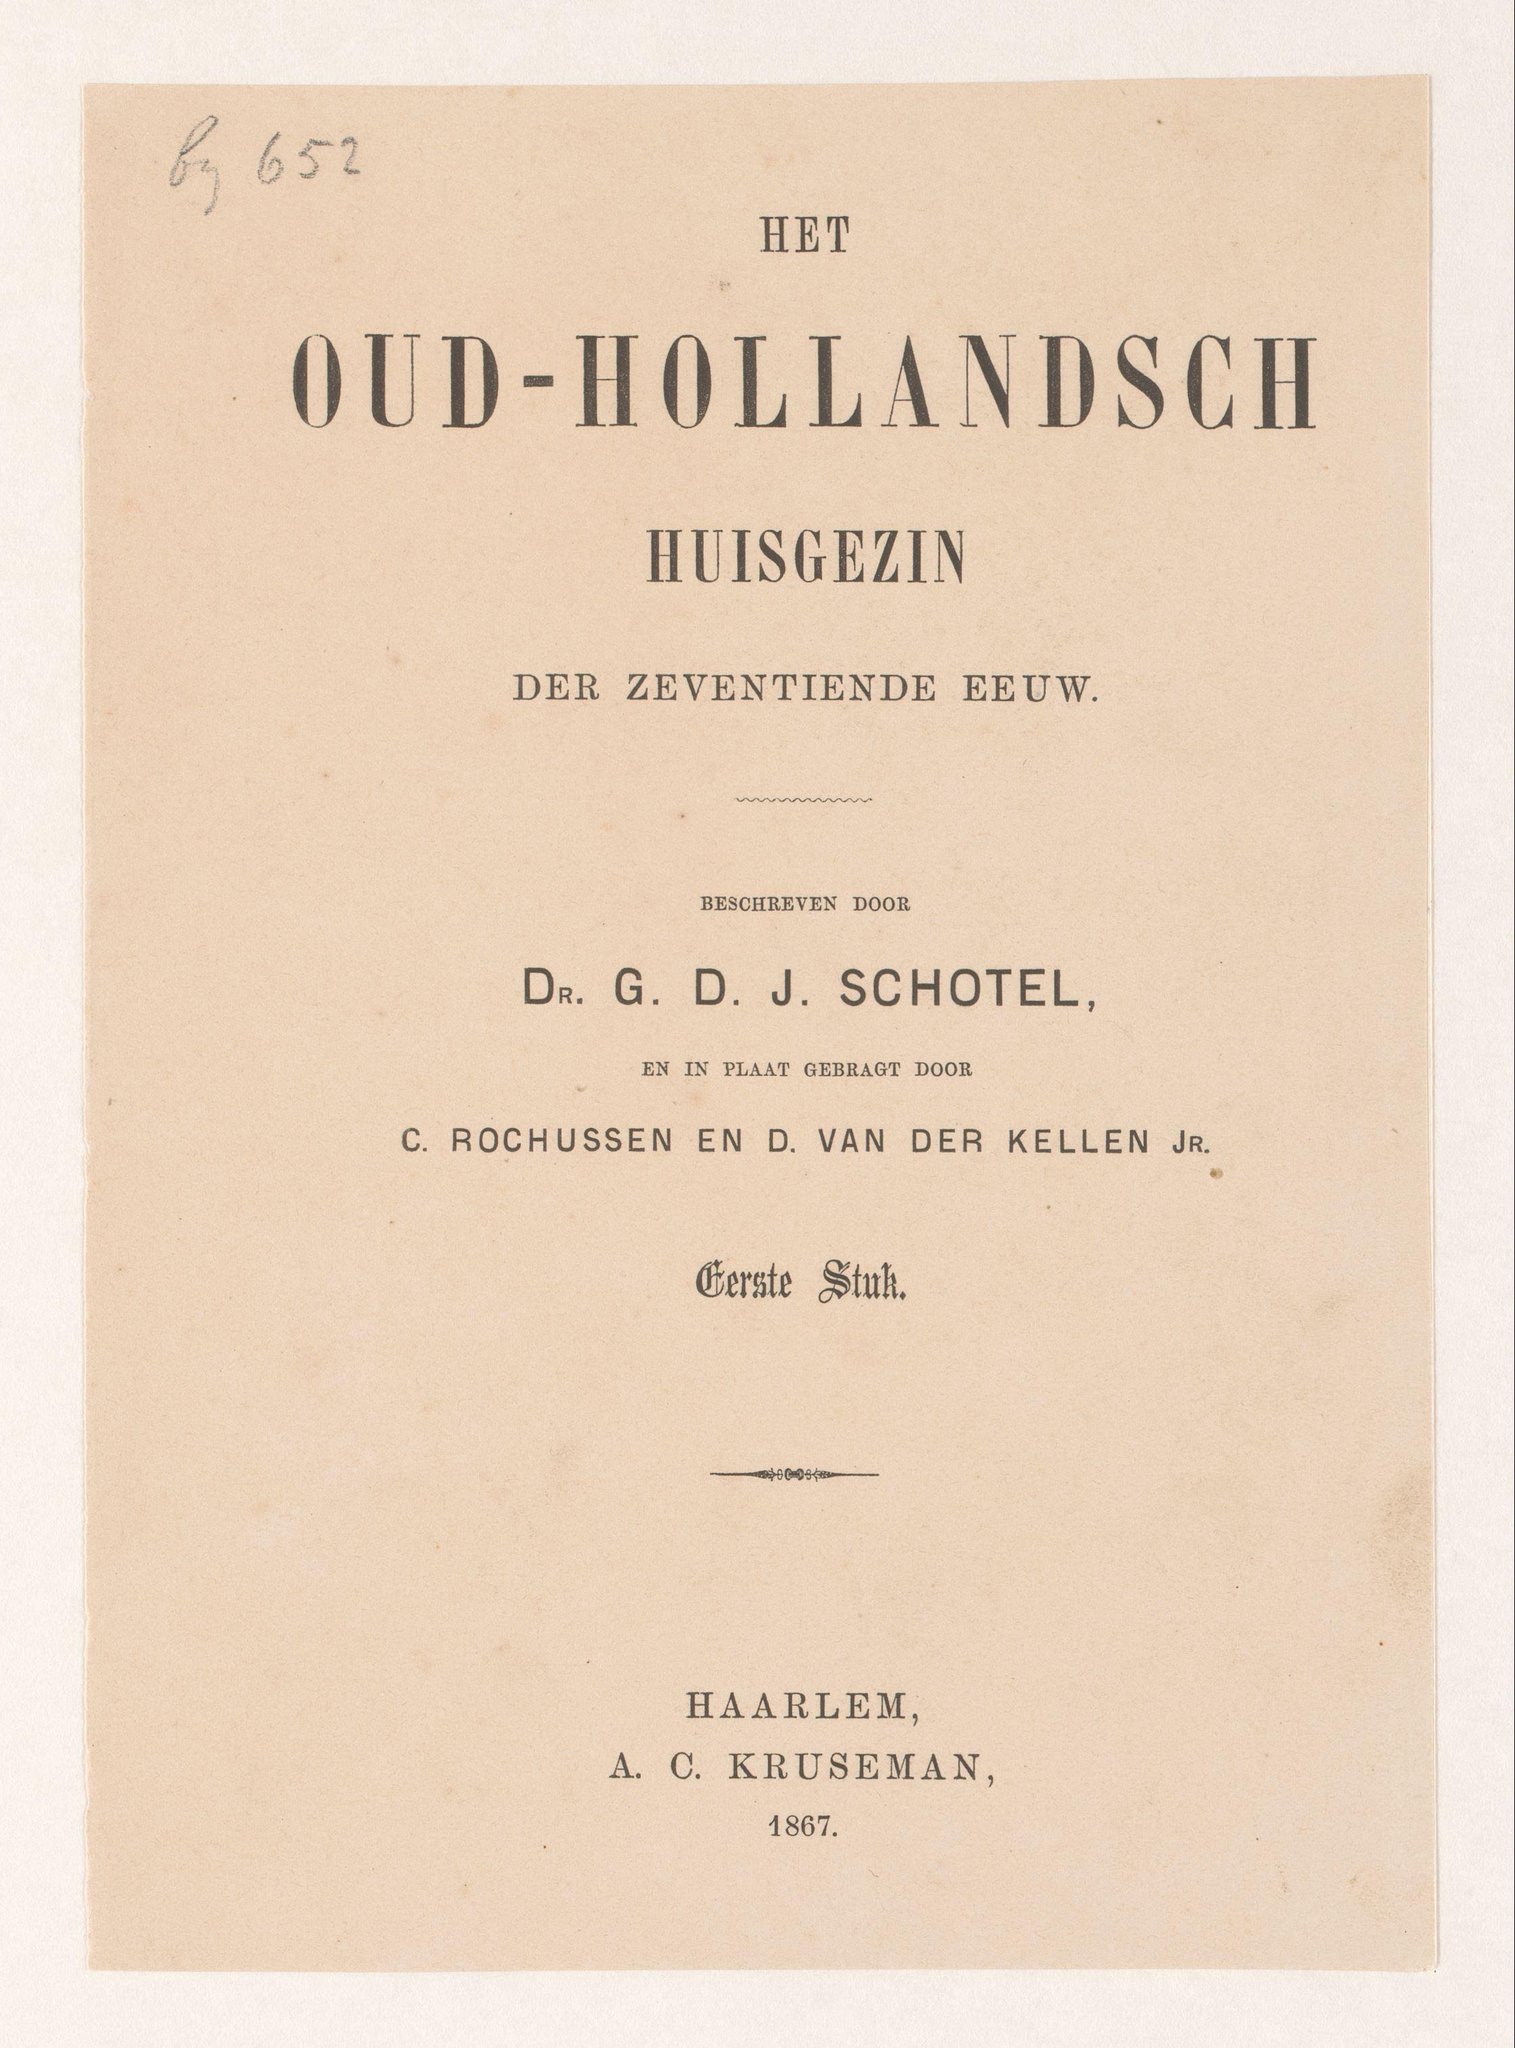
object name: print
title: Titelpagina voor: Gillis Dyonisius Jacobus Schotel, Het Oud-Hollandsch huisgezin, Eerste Stuk, 1867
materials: paper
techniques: letterpress printing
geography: haarlem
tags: title-page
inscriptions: collector's mark: Lugt 2228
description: Titelpagina voor: Schotel, Gillis Dyonisius Jacobus. Het Oud-Hollandsch huisgezin, Eerste Stuk. Haarlem: Kruseman, Arie Cornelis, 1867.